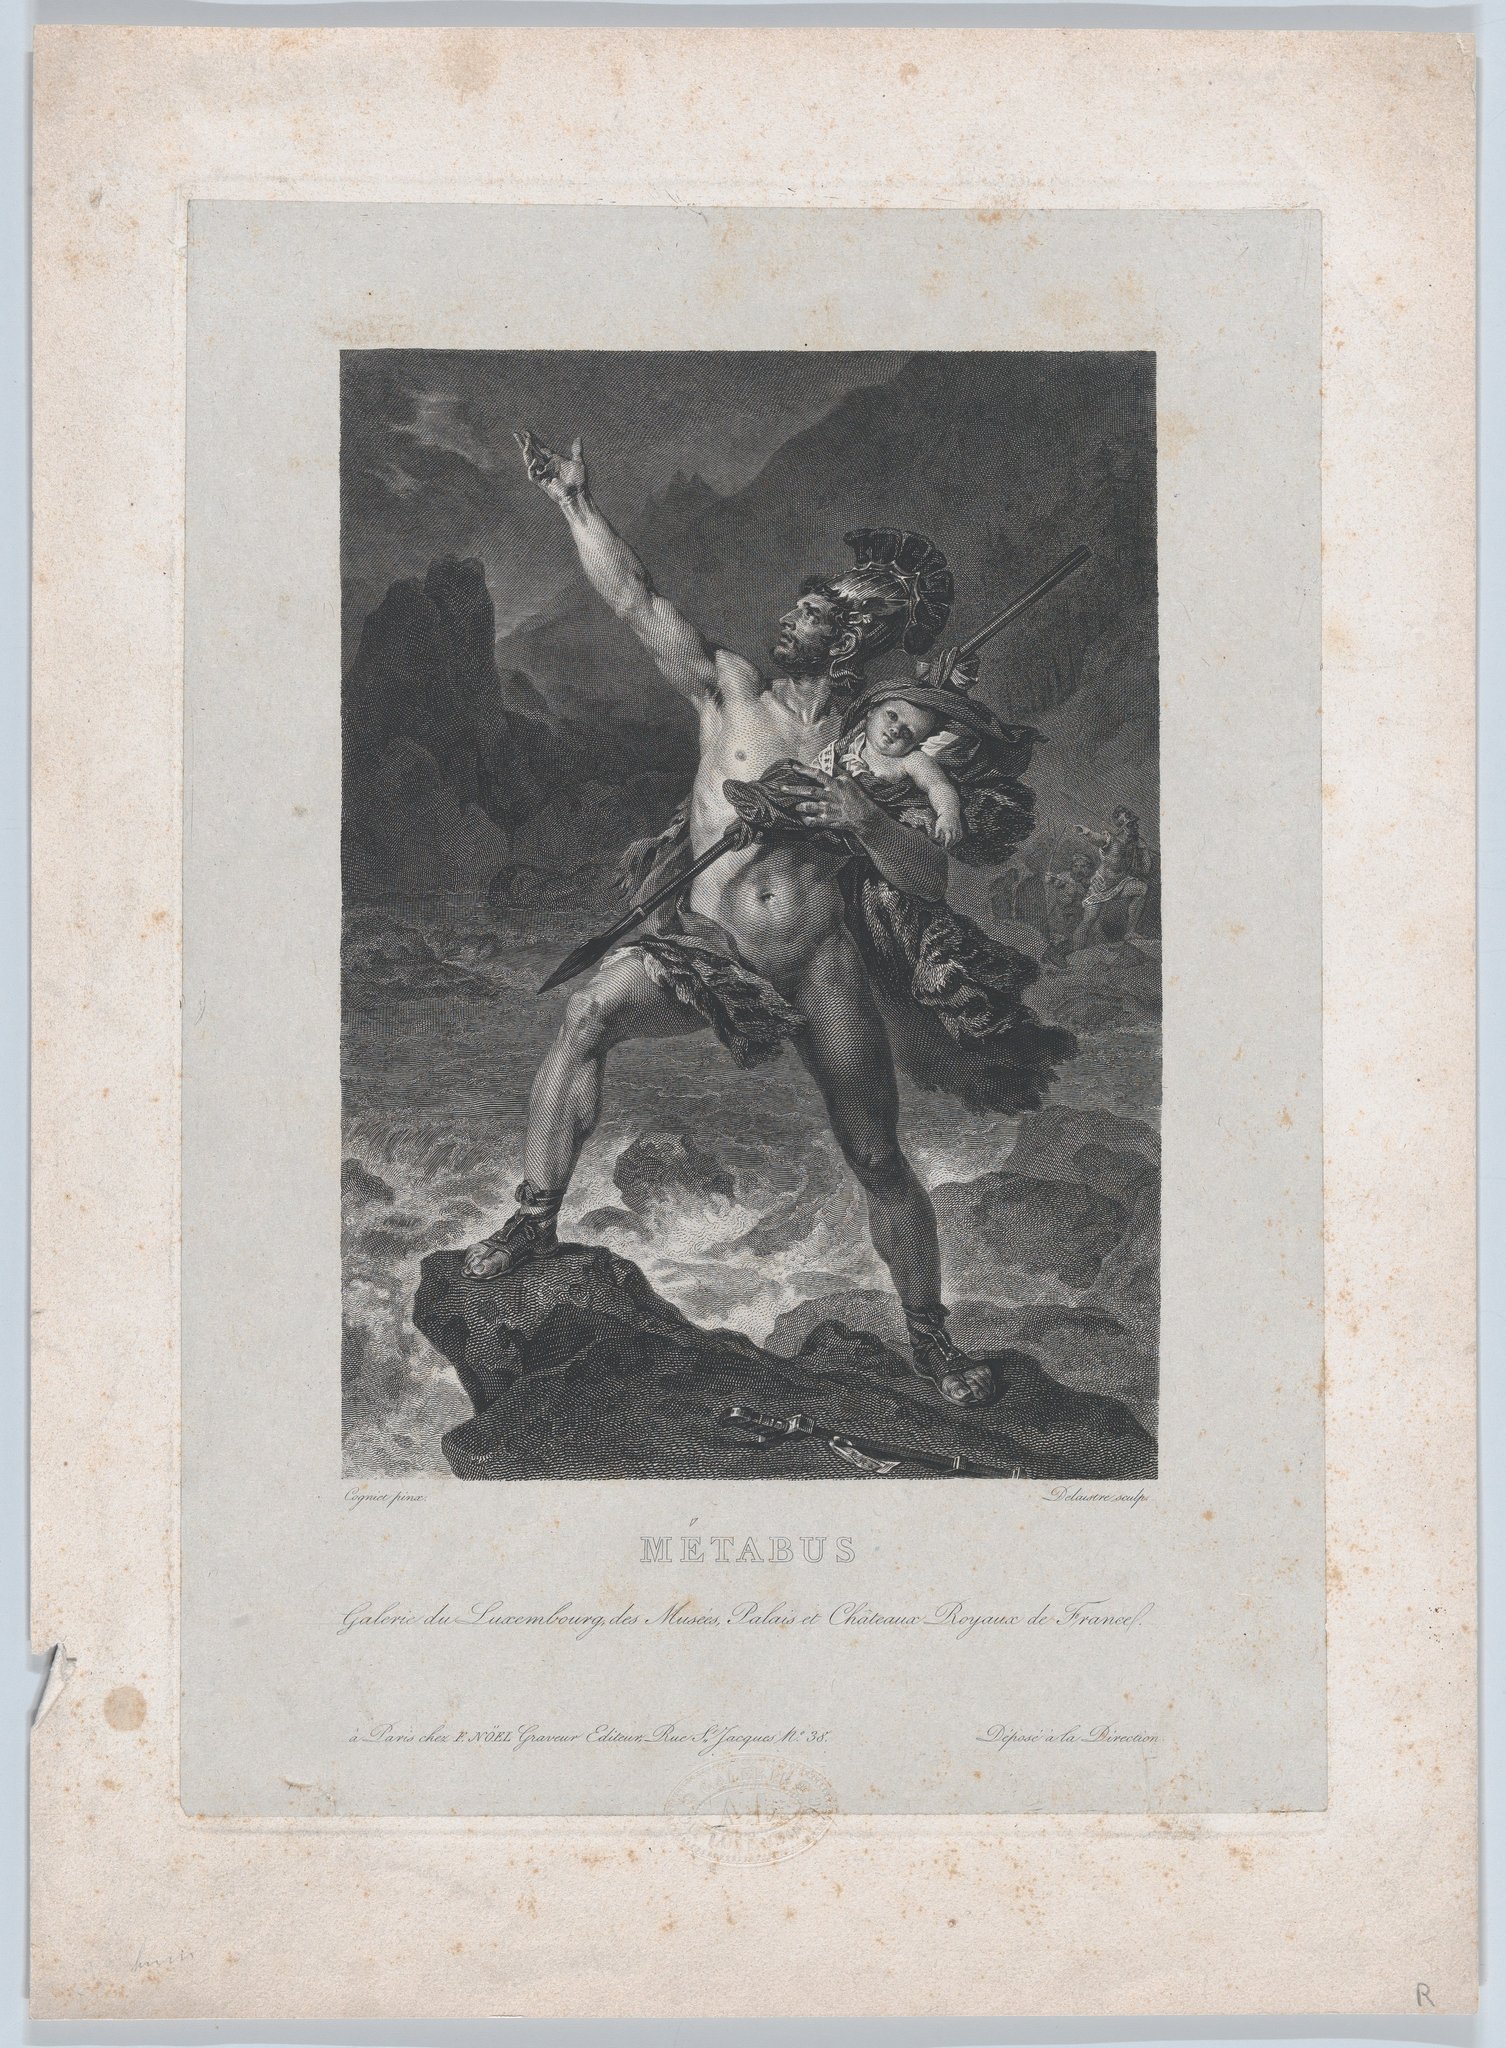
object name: print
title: Métabus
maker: louis jean désiré delaistre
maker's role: artist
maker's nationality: french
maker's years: 1800-1871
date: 1830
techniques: printmaking, engraving, etching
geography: paris